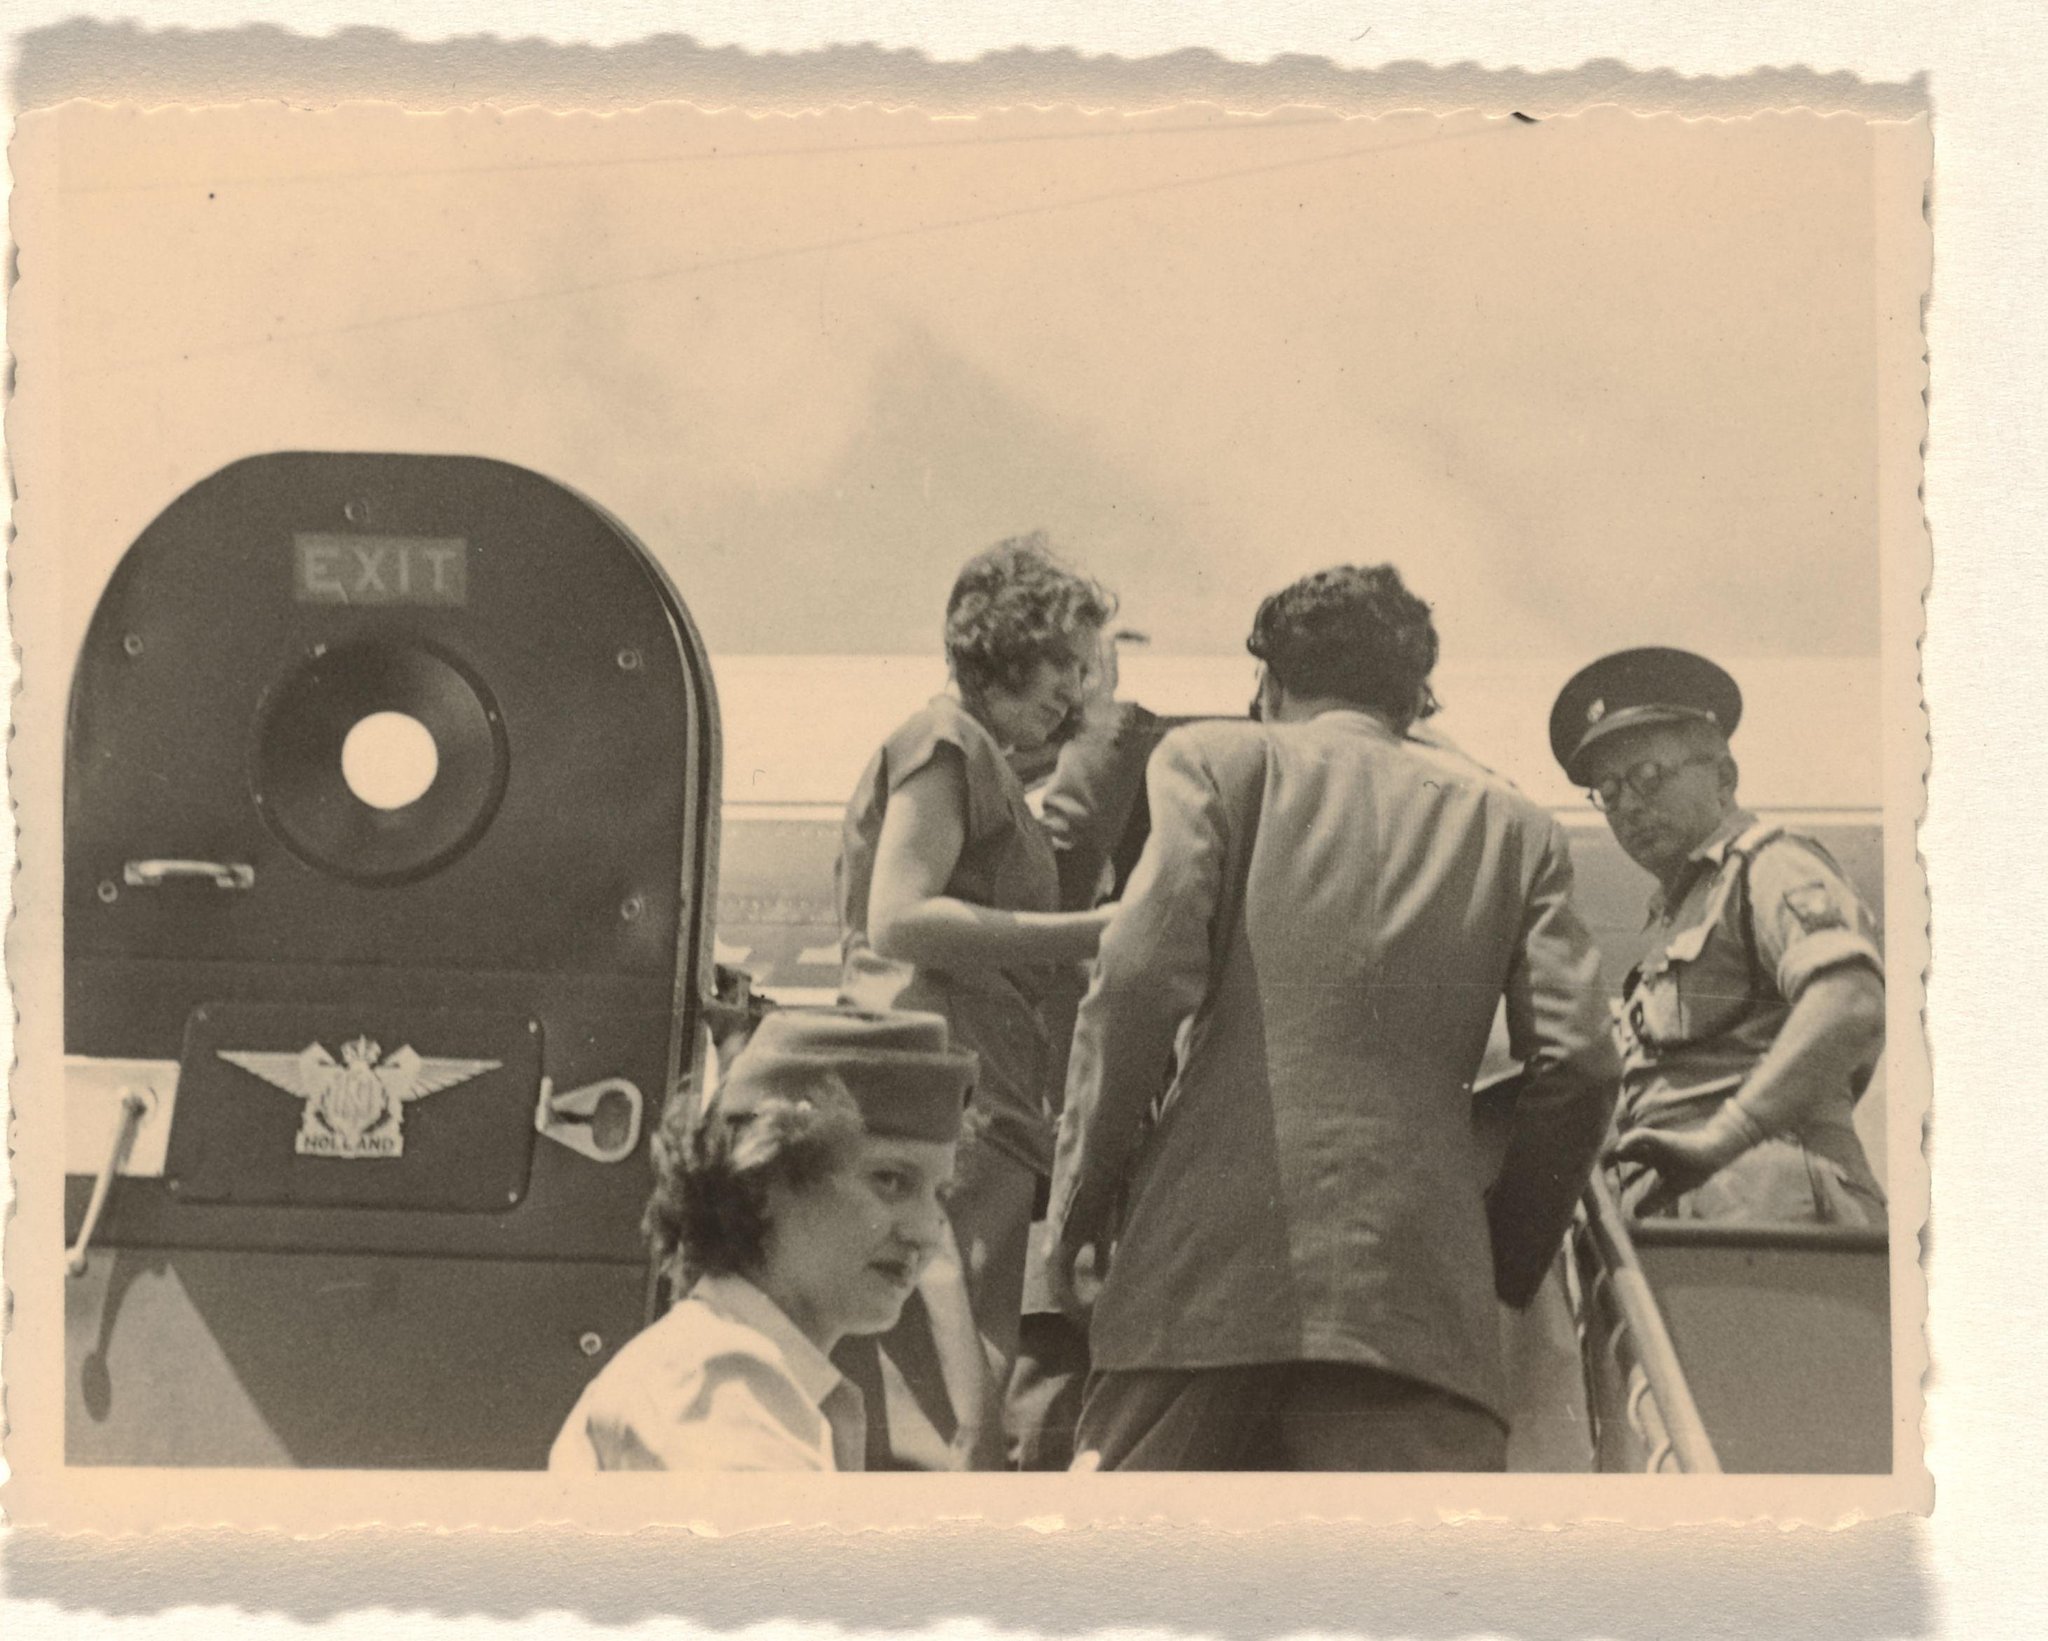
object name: photograph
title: Isabel Wachenheimer bij de ingang van een vliegtuig, voor een toegangstrap met passagiers en bemanningsleden van het vliegtuig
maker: Anonymous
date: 1947-1955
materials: photographic support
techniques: gelatin silver print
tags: leiden, isabel wachenheimer-elon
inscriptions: number: ‘17’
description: Isabel Wachenheimer (2e van links) bij de ingang van een vliegtuig, voor een toegangstrap met passagiers en bemanningsleden van het vliegtuig.